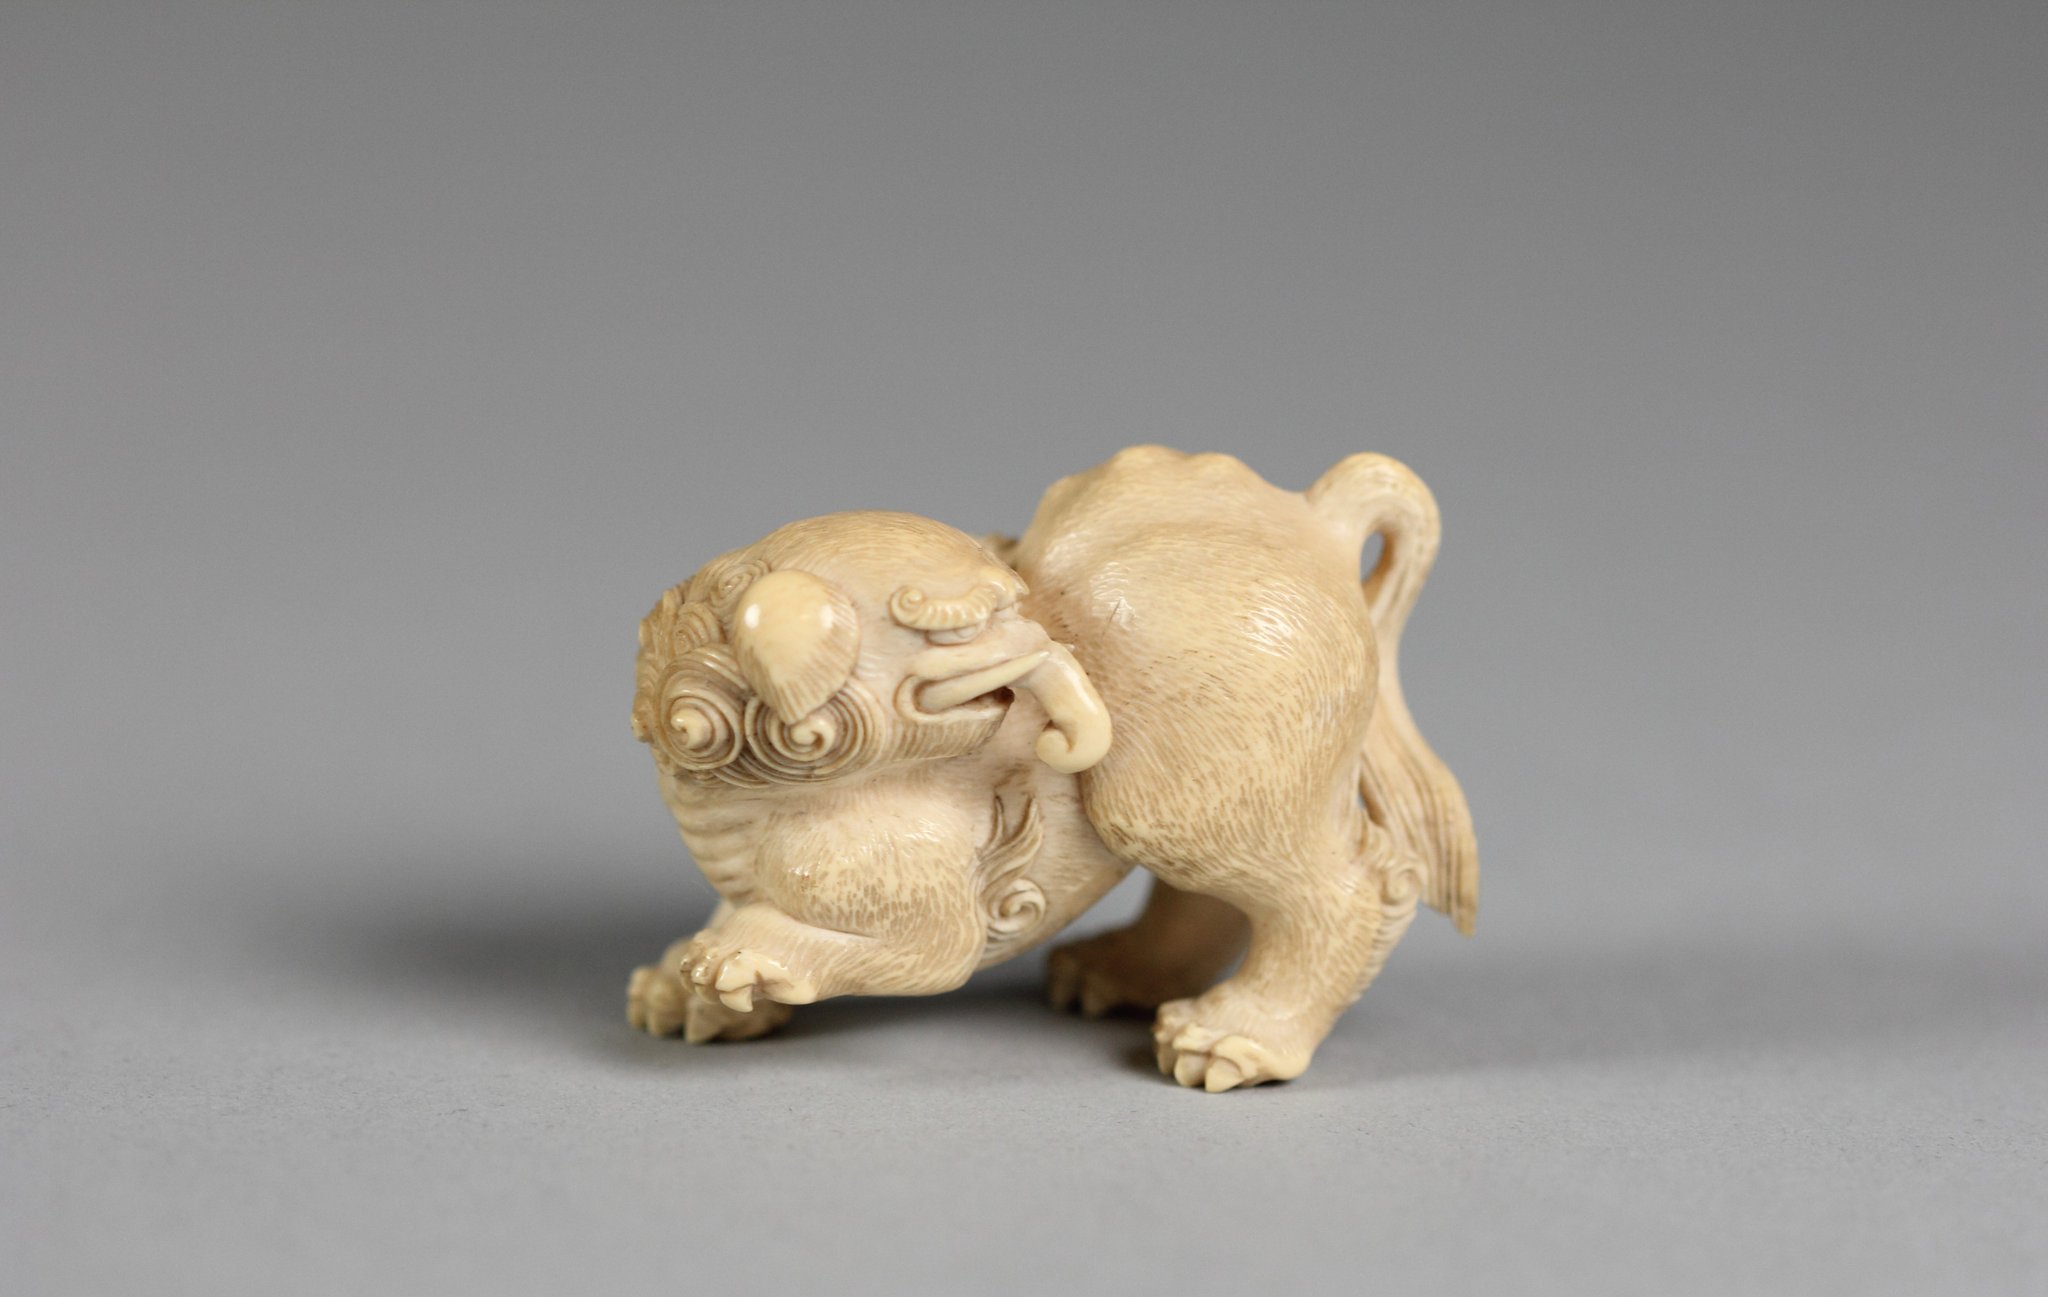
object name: netsuke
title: Netsuke of Qilin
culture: japanese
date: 1867-1900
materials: ivory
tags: mythical creatures